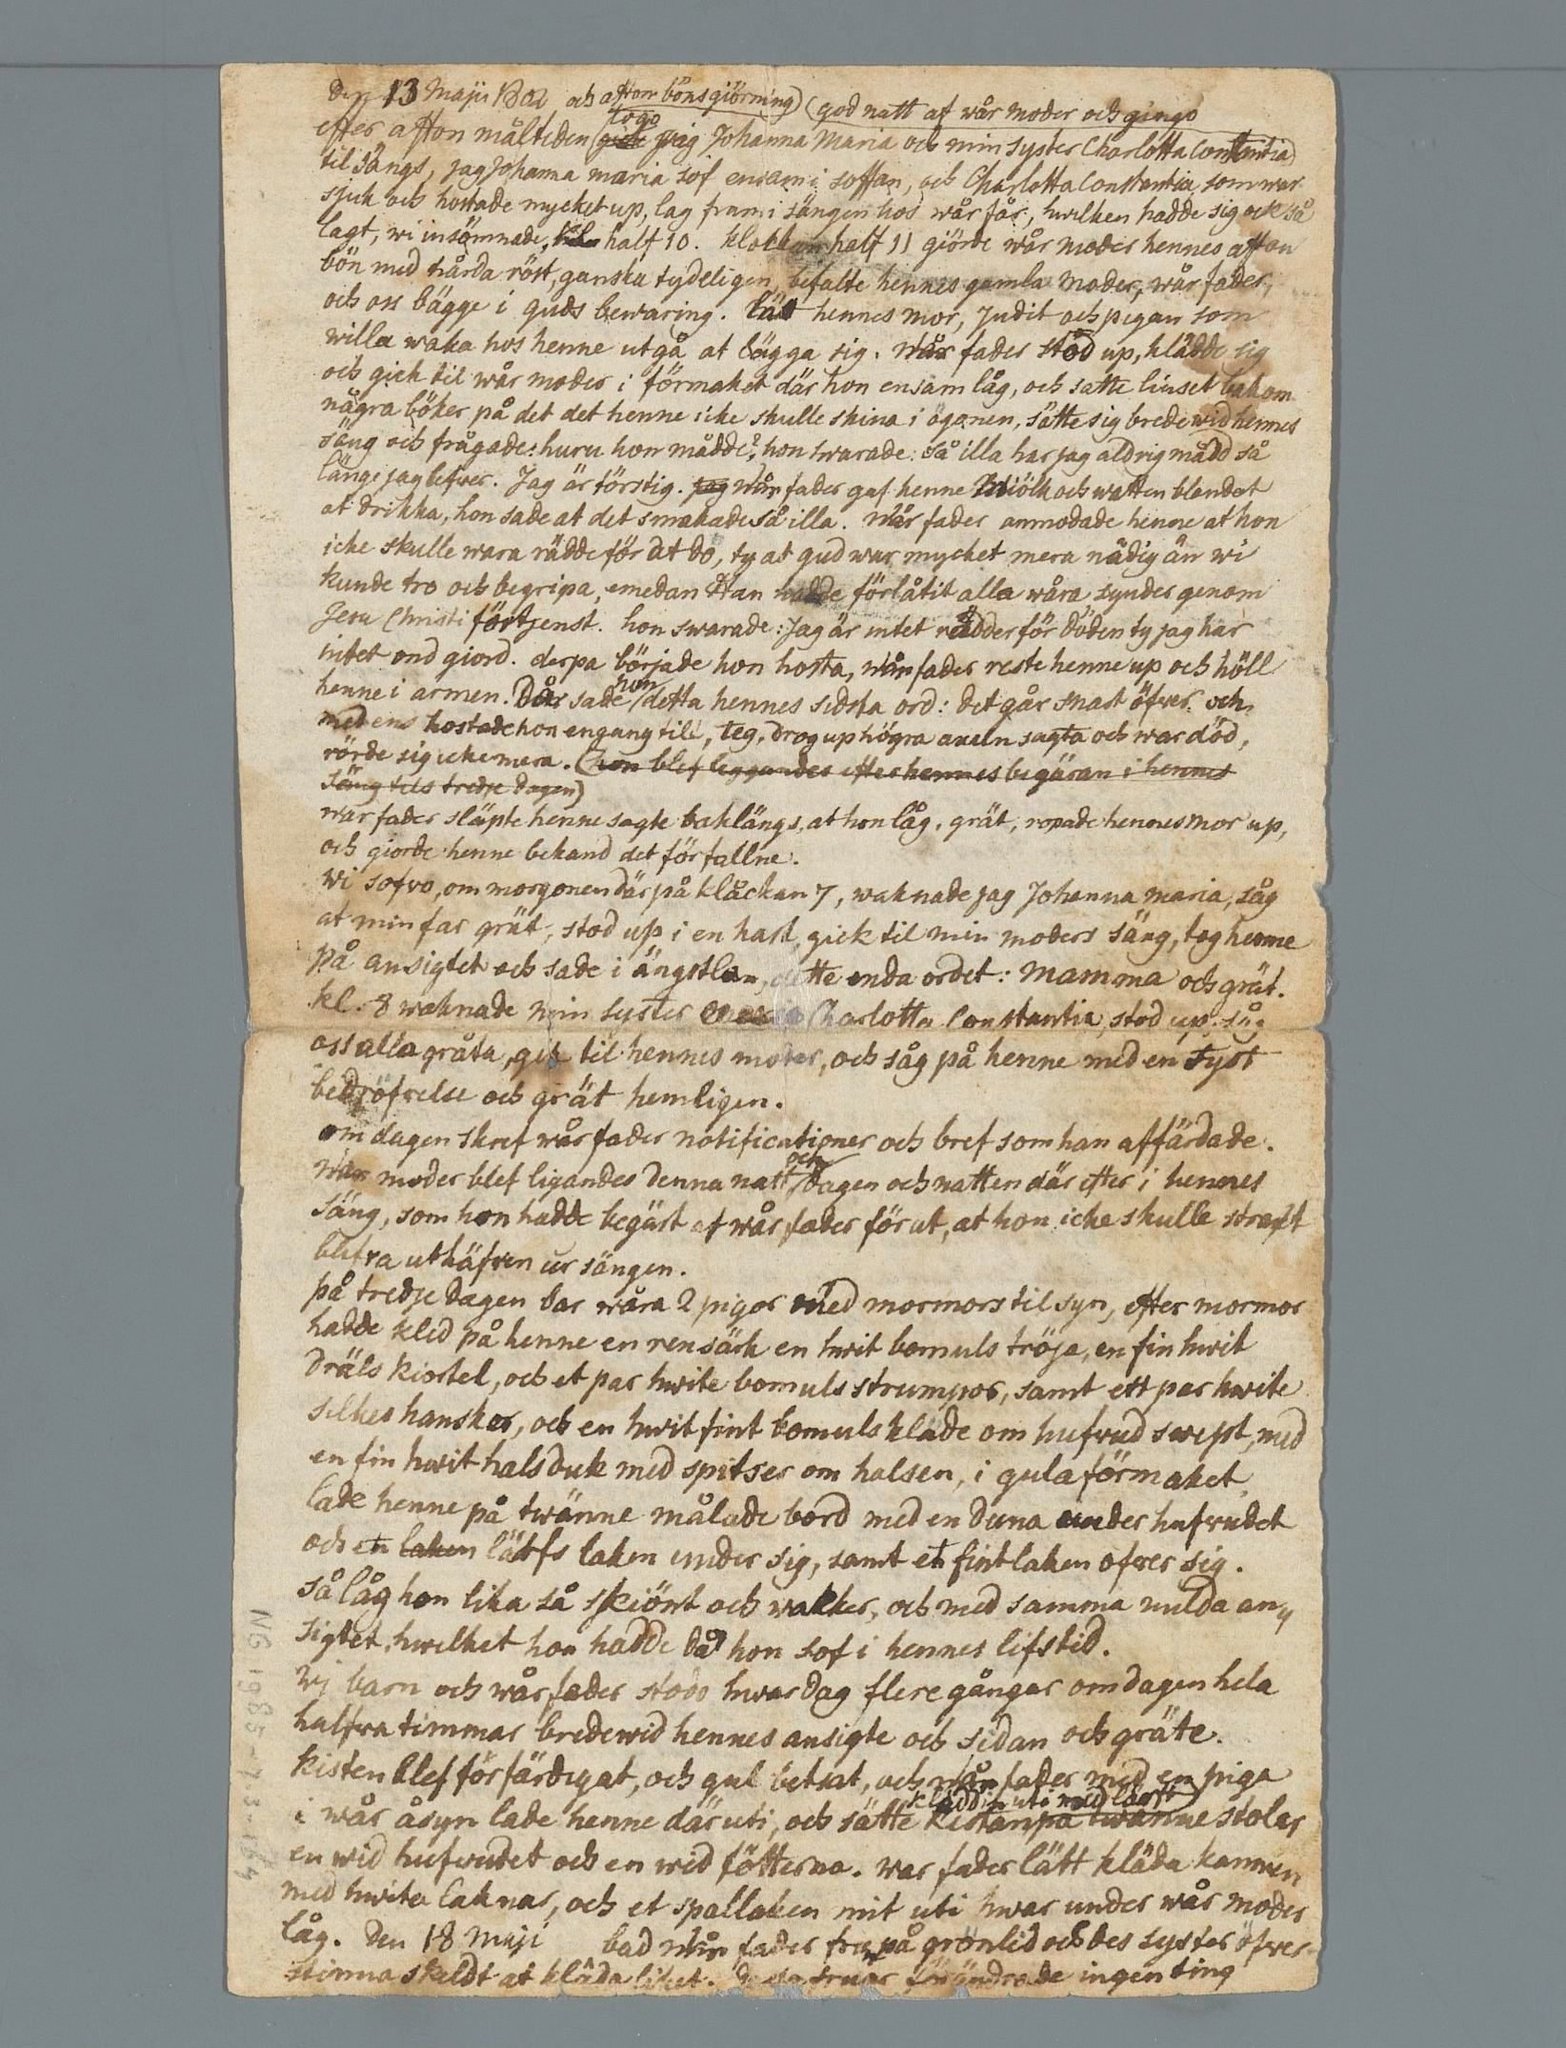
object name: diary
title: Aantekeningen rond de dood van de vrouw van Brandes, mei 1802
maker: jan brandes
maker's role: draughtsman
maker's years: 1743-1808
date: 1802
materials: paper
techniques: writing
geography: skälsebo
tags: skälsebo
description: Blad uit dagboek van Jan Brandes. Dicht beschreven velletje met een aantekening van 13 mei 1802 (dood van vrouw Brandes) en 21 mei (begrafenis). Geschreven alsof door dochter Johanna Maria maar het handschrift is dat van Brandes zelf.